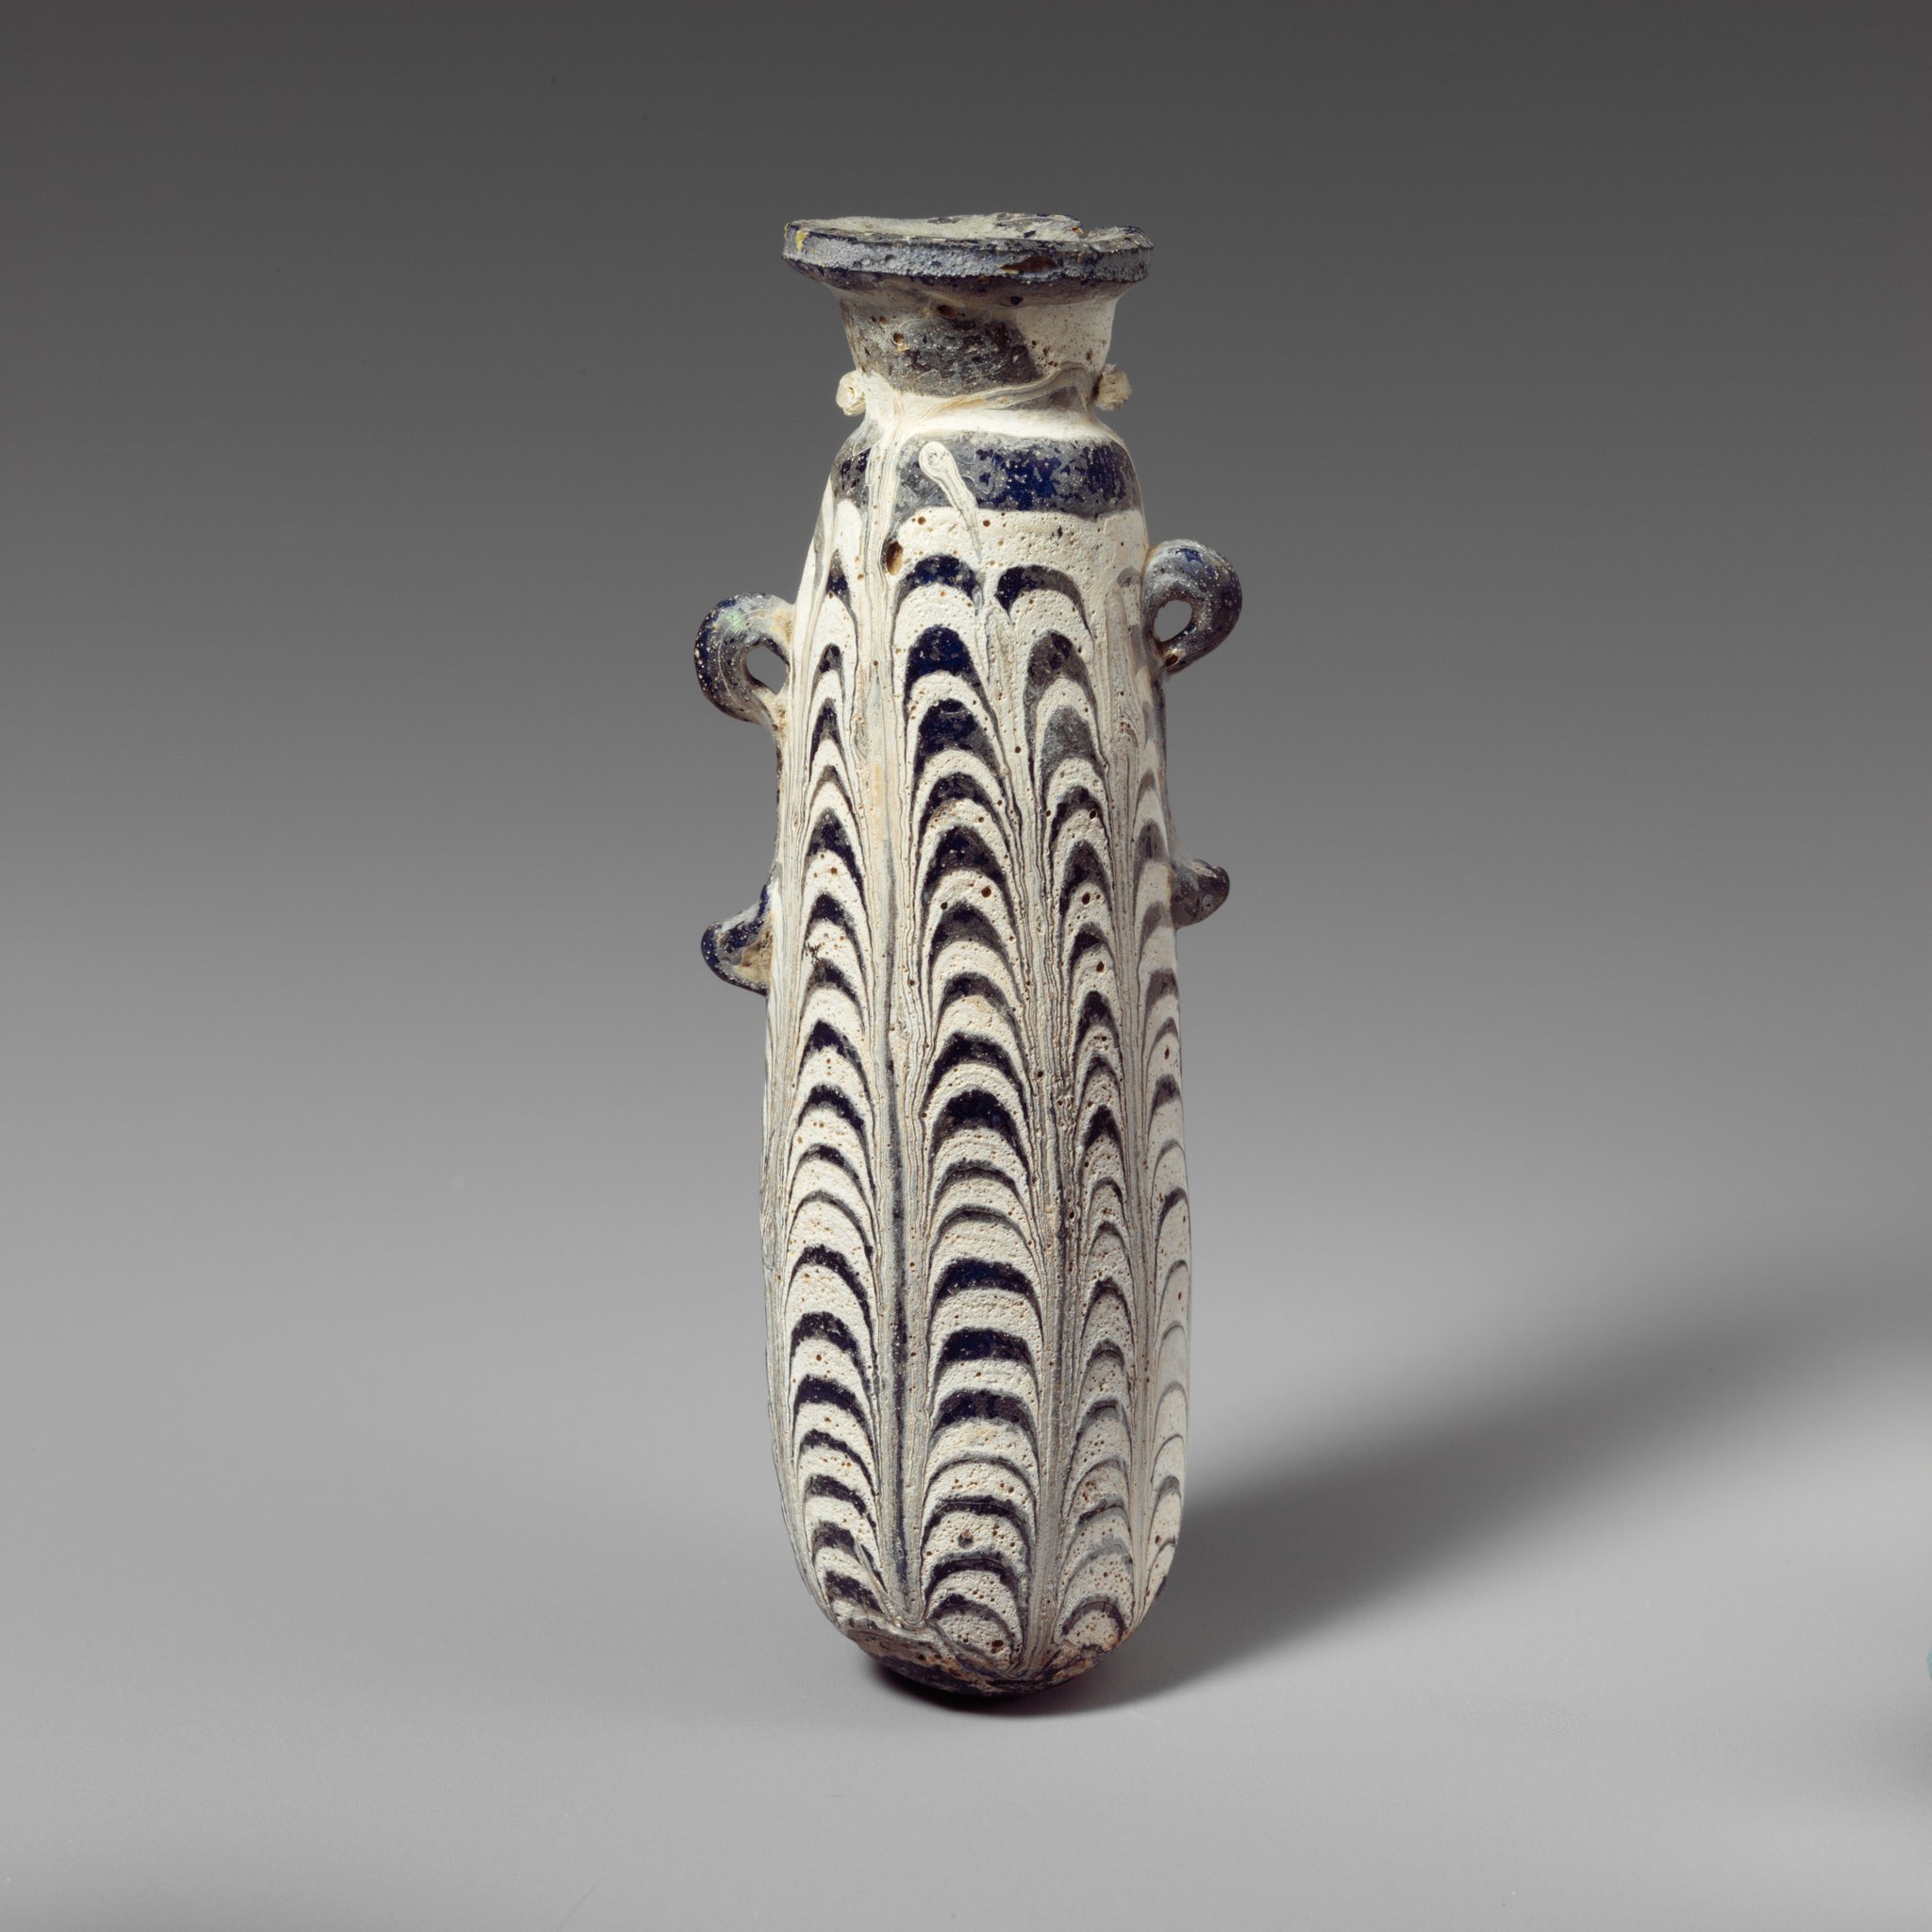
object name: alabastron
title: Glass alabastron (perfume bottle)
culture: greek, eastern mediterranean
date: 534-401 BCE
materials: glass